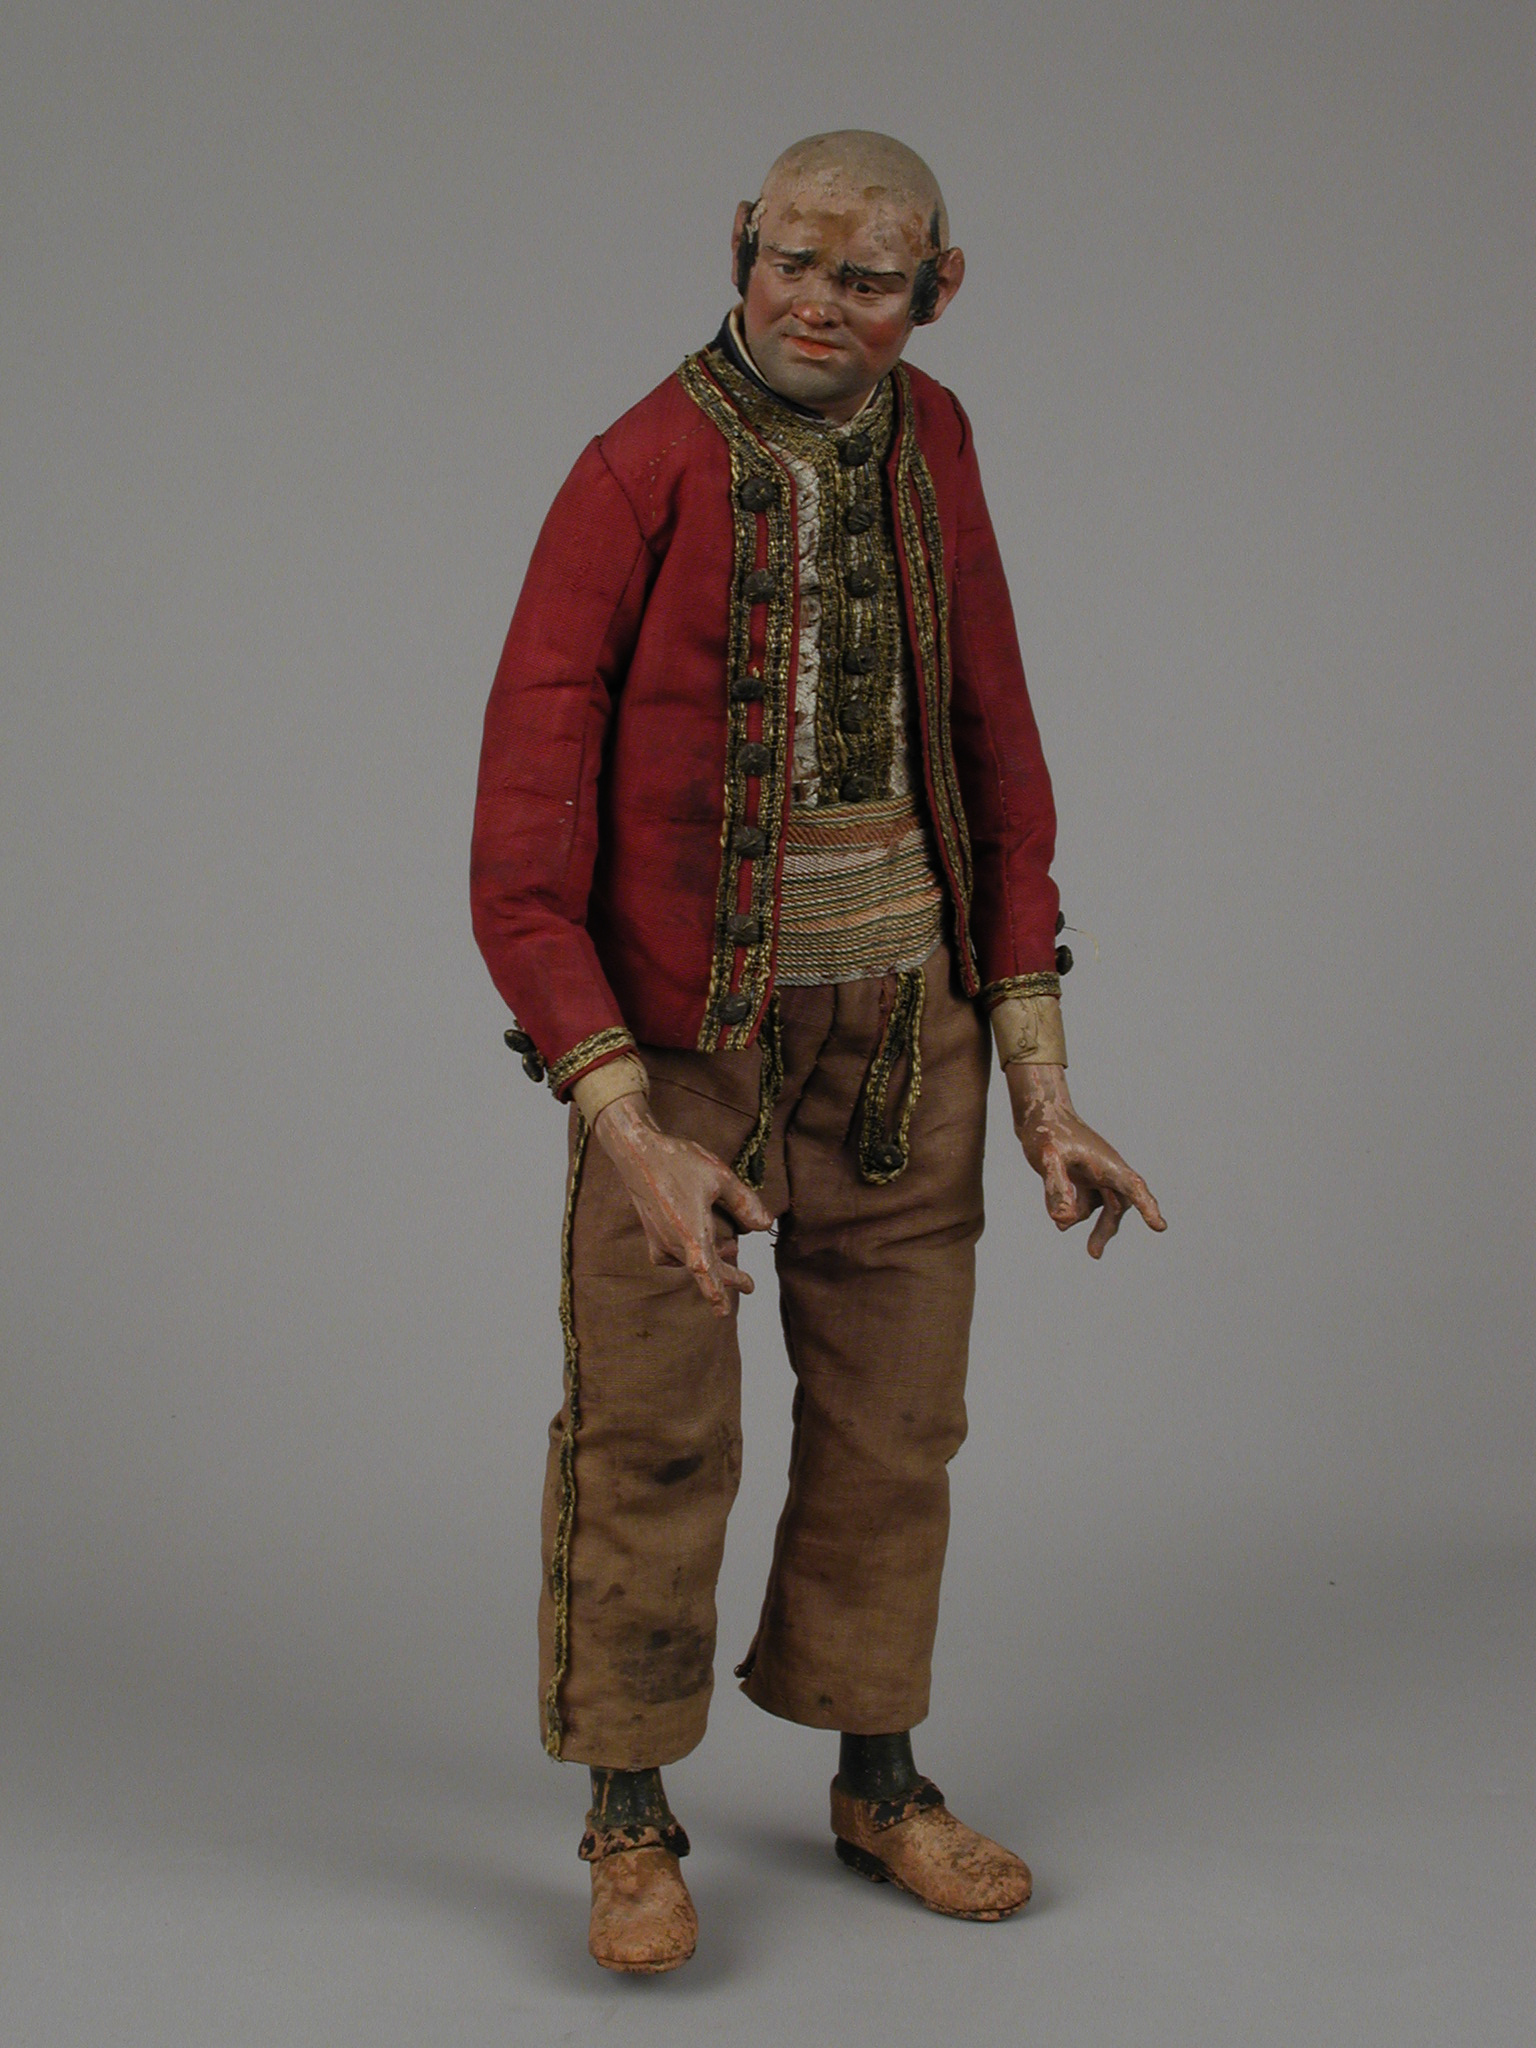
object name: crèche figure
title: Man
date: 1751-1800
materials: cotton, silk, thread, terracotta, fiber, metal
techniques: polychrome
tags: men